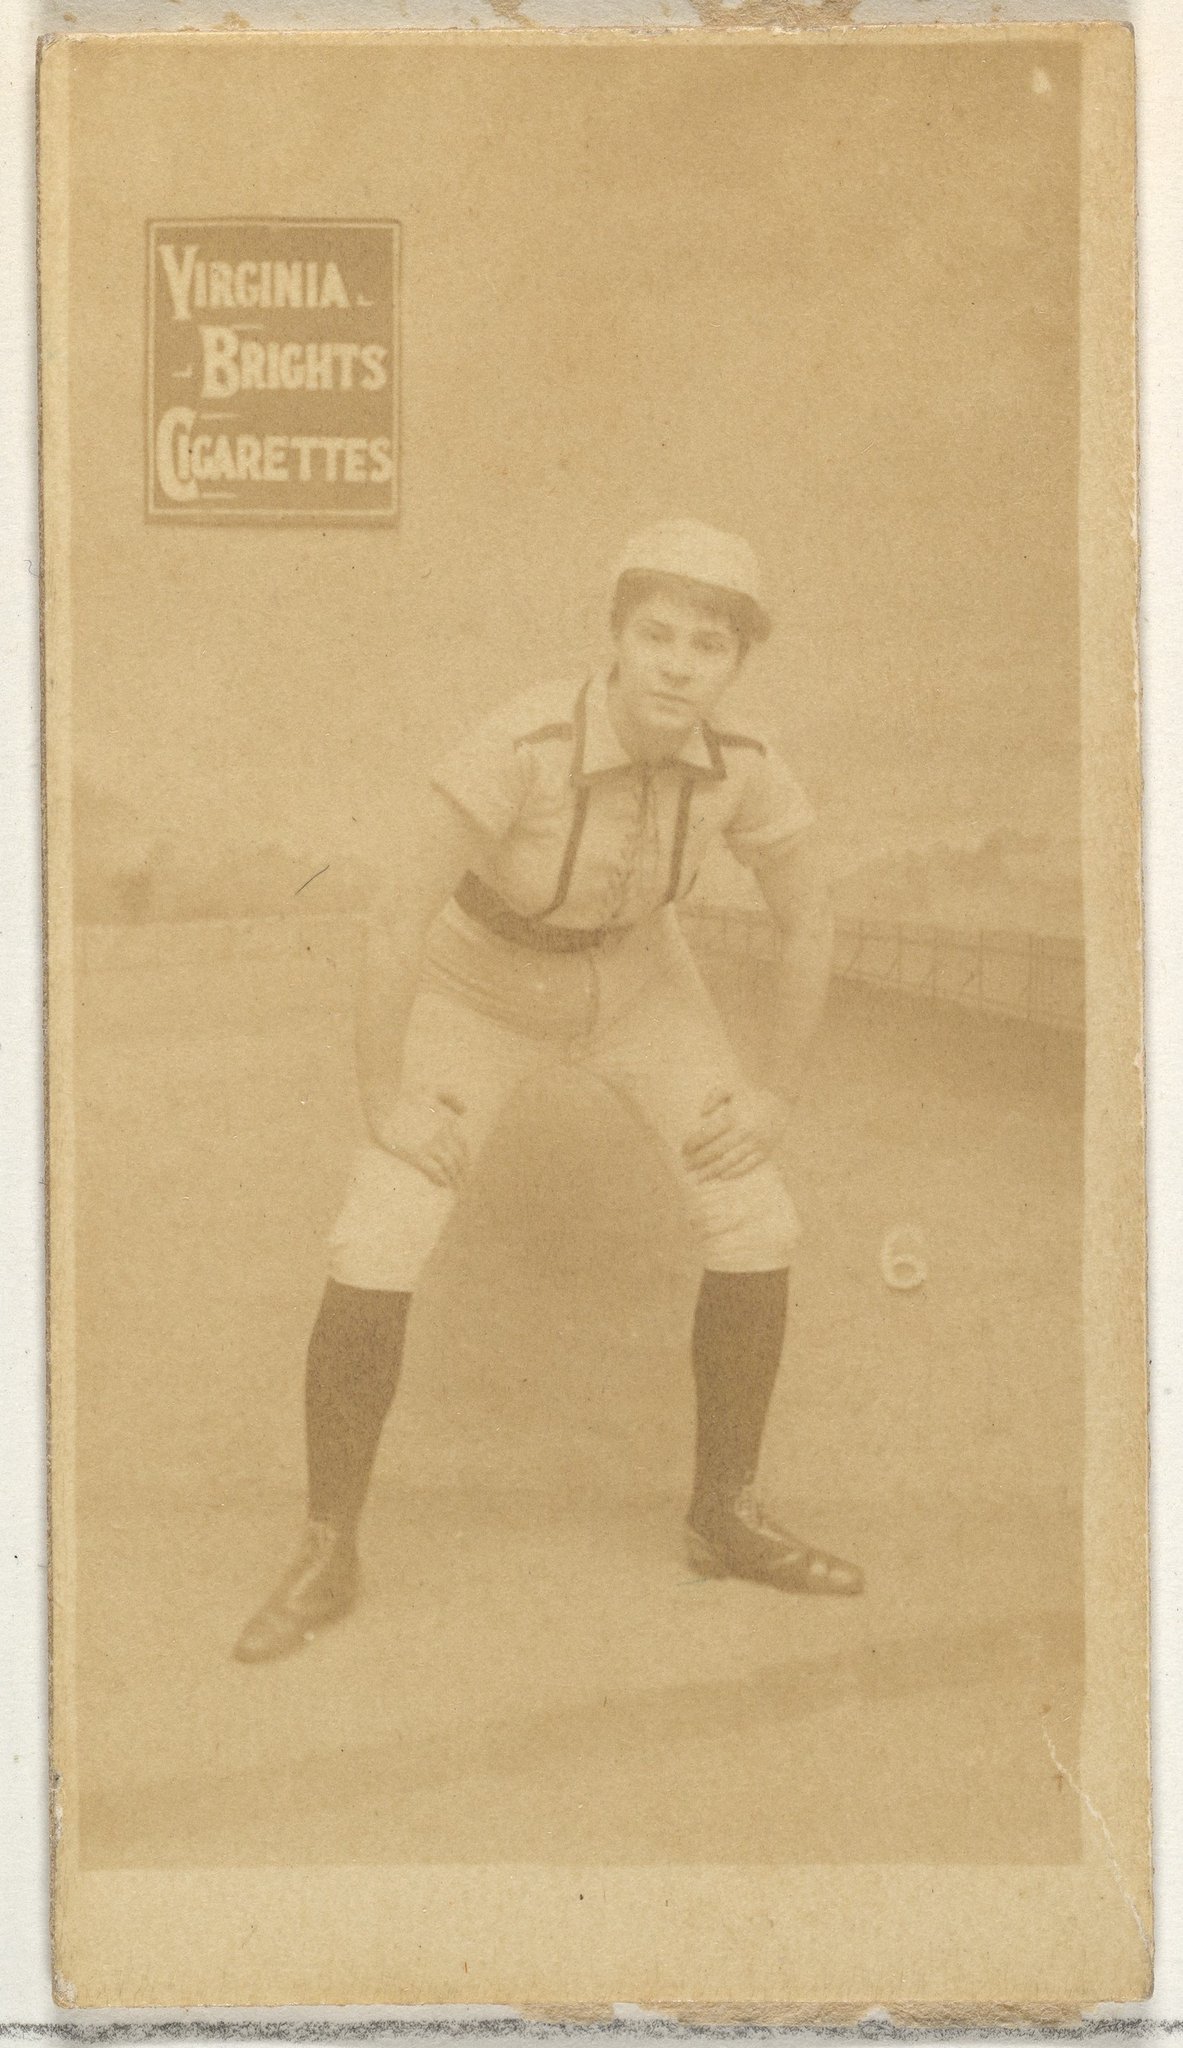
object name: baseball card, photograph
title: Card 6, from the Girl Baseball Players series (N48, Type 2) for Virginia Brights Cigarettes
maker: allen & ginter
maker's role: publisher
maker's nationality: american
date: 1886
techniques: albumen silver print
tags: portraits,women,baseball,athletes